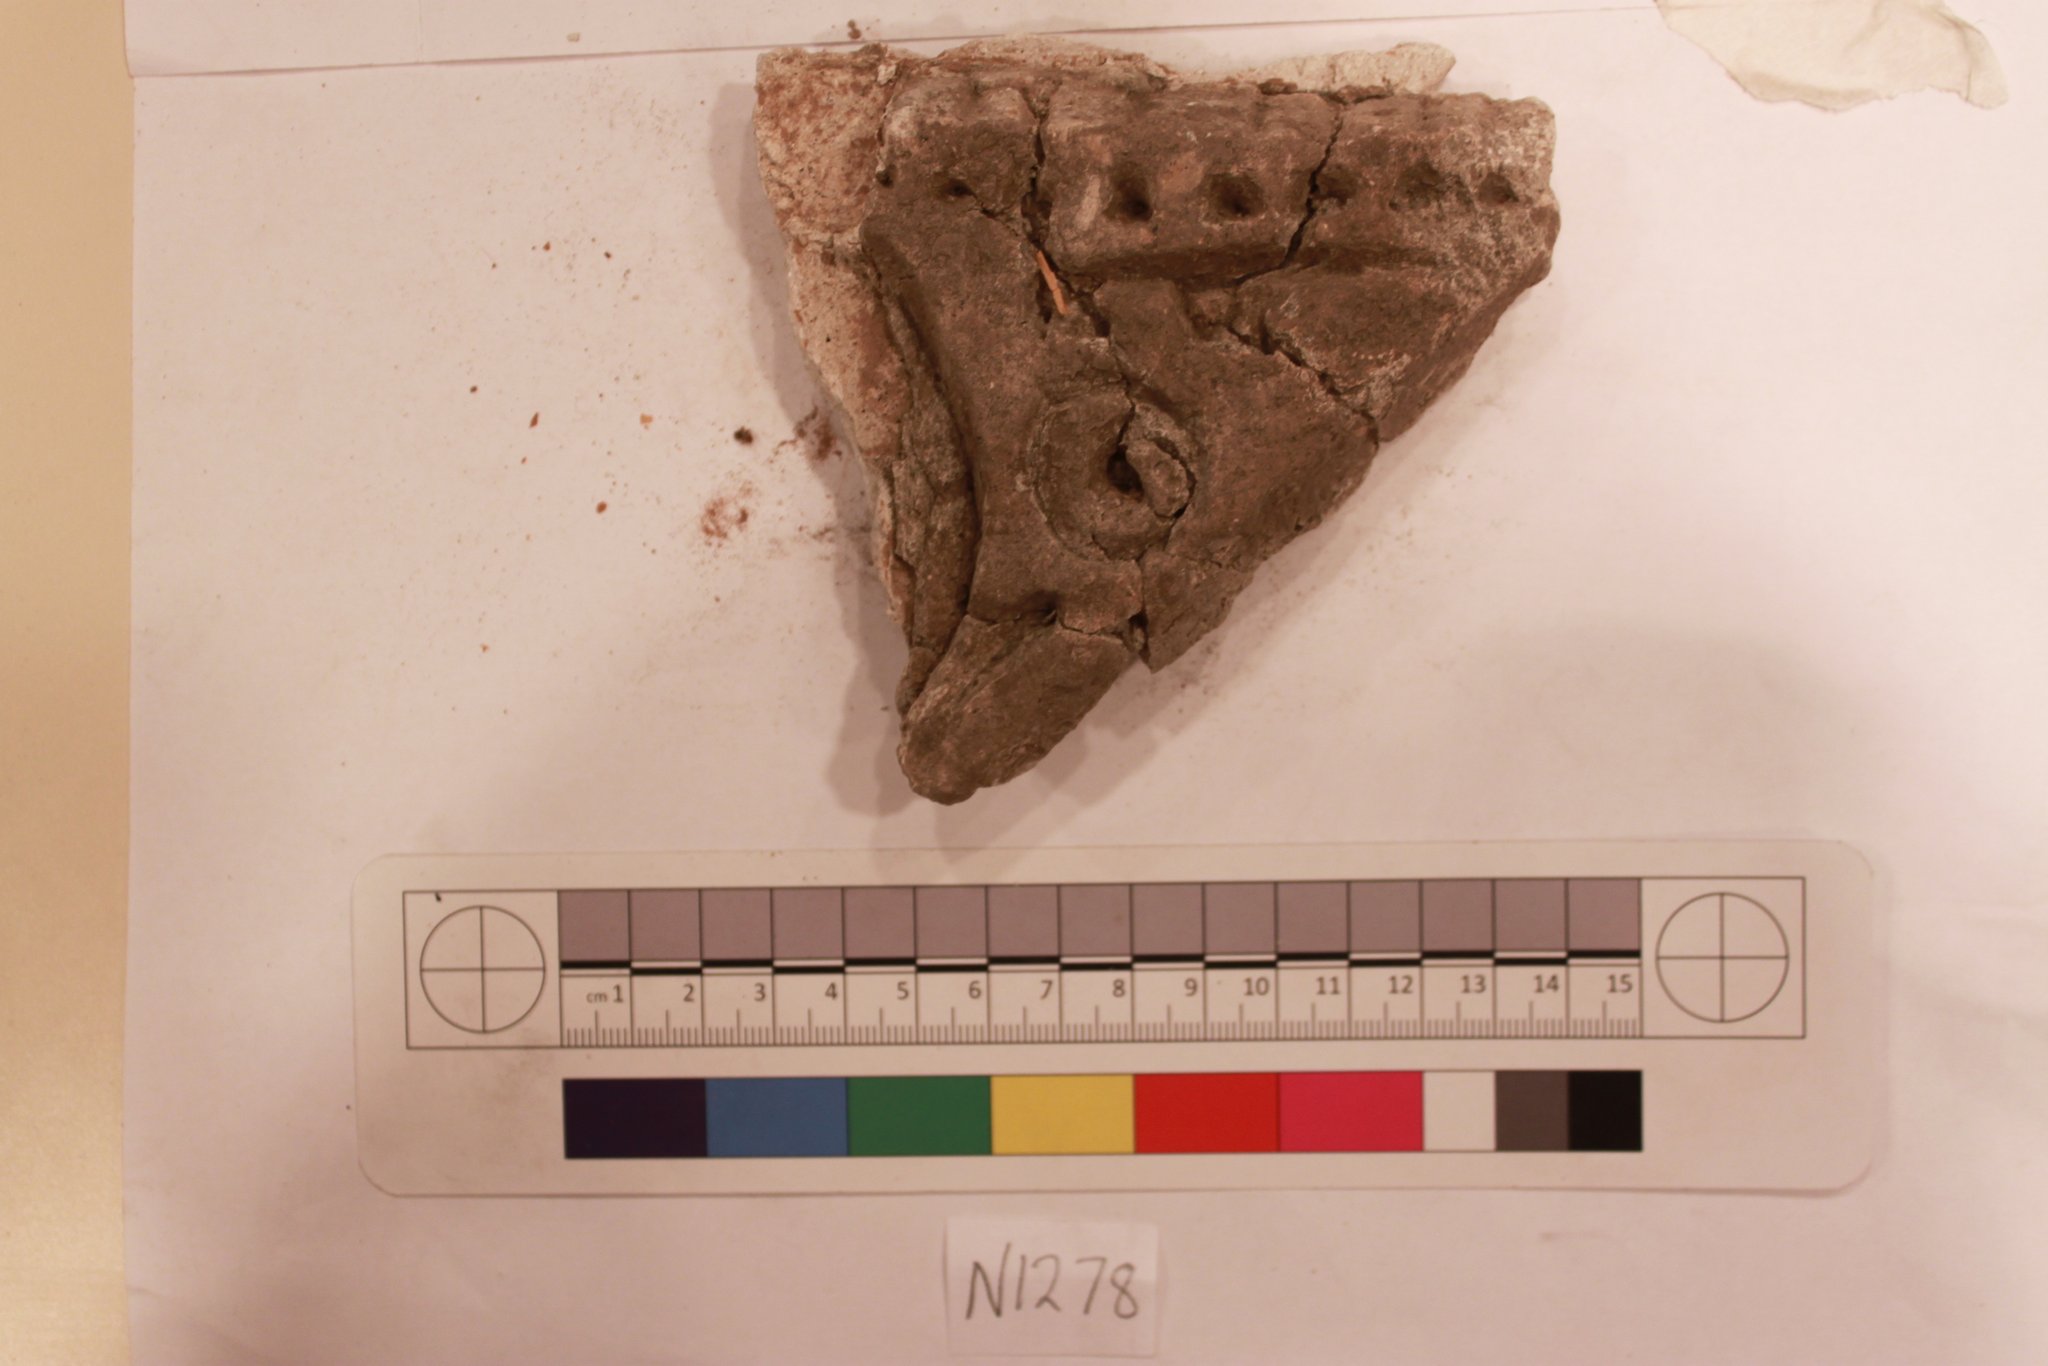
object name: fragment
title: Stucco Fragment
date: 701-1200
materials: plaster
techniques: carving, painting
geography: iran